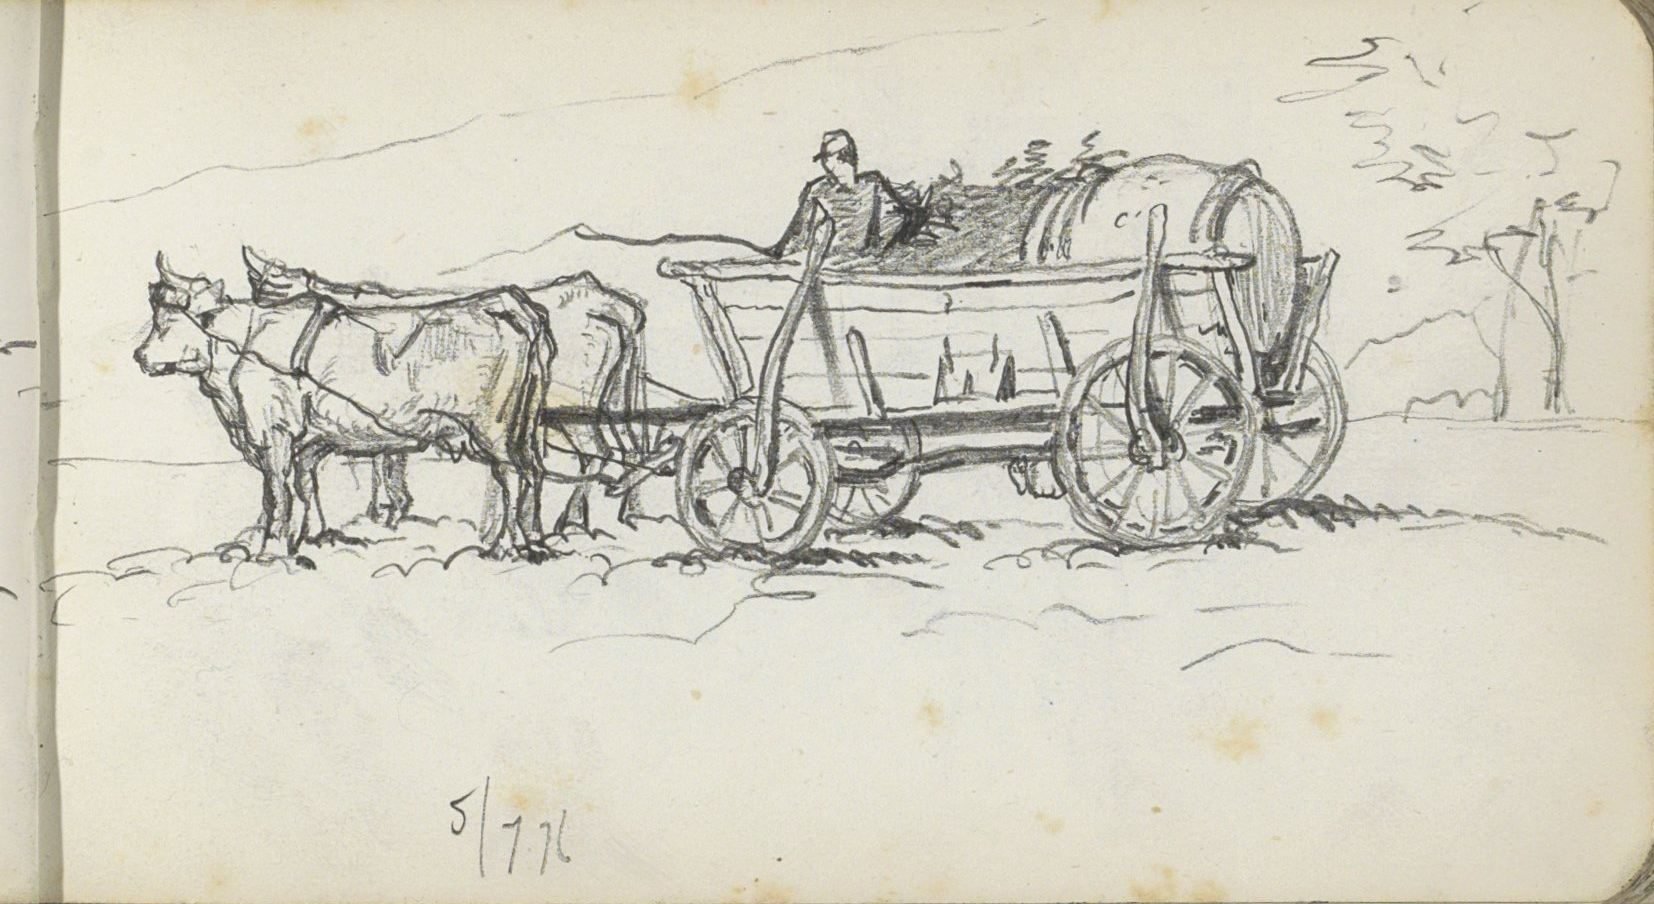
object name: sketchbook leaf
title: Ossenkar op het land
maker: geo poggenbeek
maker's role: draughtsman, painter, print maker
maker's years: 1853-1903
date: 1807-1876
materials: paper, pencil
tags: ox, (farm) wagon, freight wagon, cart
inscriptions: date: ‘5/7 76’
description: Op de kar zit een man met een zweep. Blad 20 recto uit een schetsboek met 69 bladen.